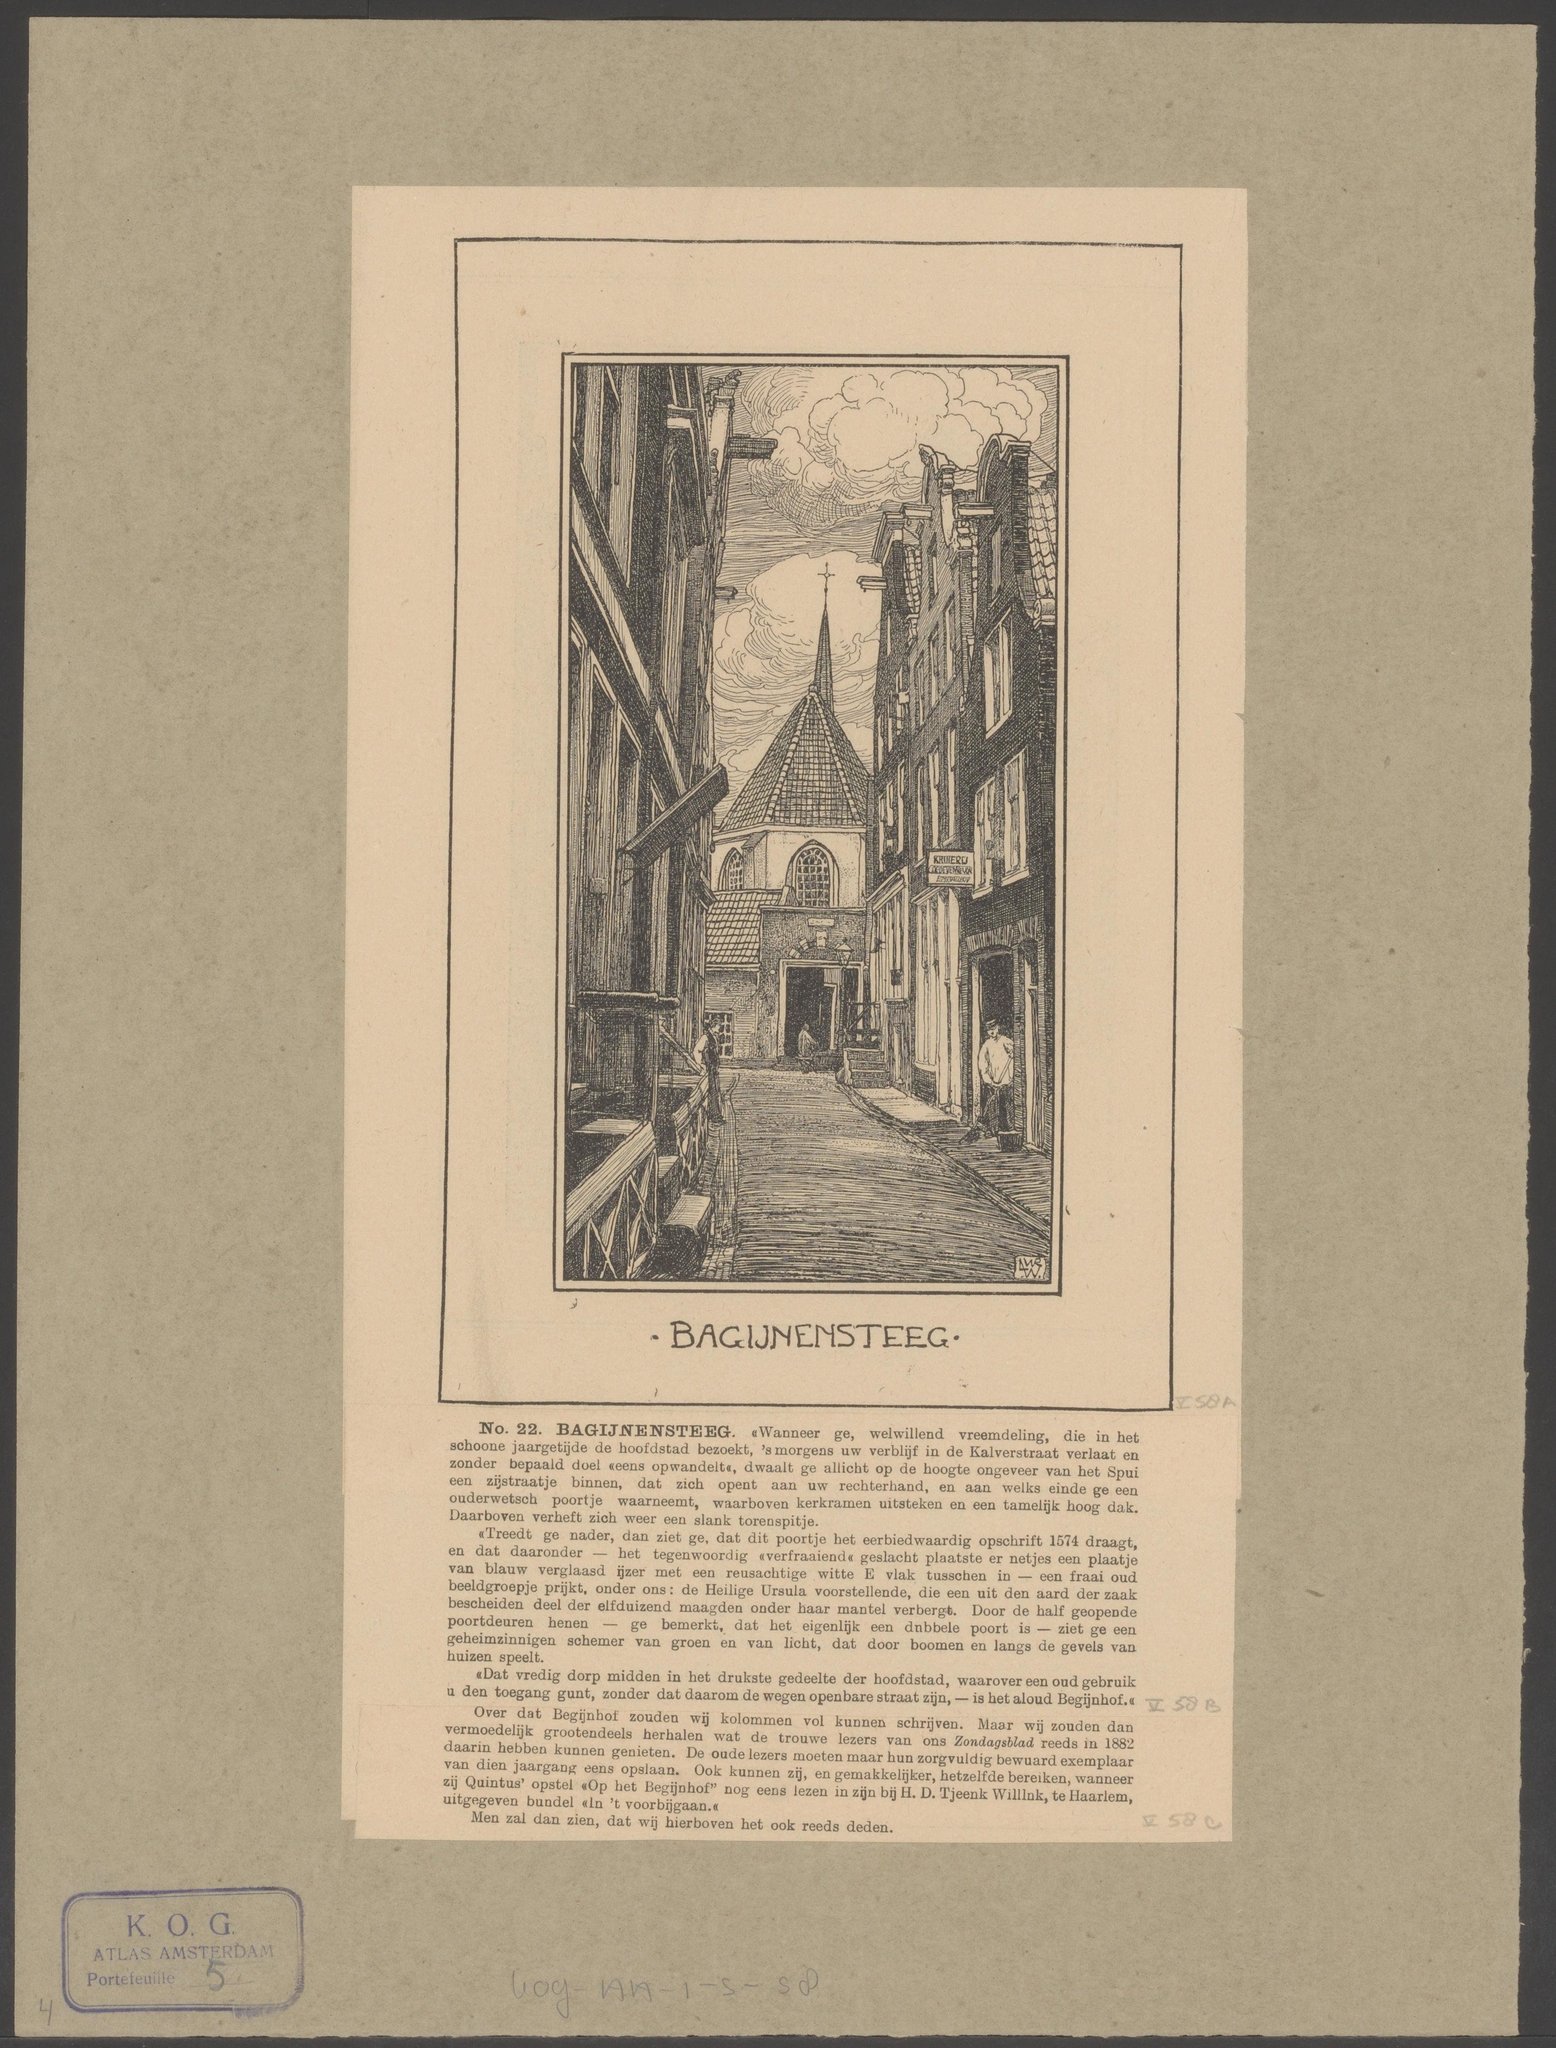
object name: photomechanical print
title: Gezicht op de Begijnensteeg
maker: willem wenckebach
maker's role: designer, draughtsman, painter, print maker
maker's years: 1860-1937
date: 1870-1923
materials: paper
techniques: letterpress printing, line block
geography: amsterdam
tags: city-view in general; 'veduta', church (exterior), the usual house or row of houses, street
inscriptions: collector's mark: ‘5’ Lugt 1641b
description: Onderwerpsrubriek binnen de Atlas Amsterdam: Begijnensloot (Gedempte), Bagijnhofsteeg, Beulingsloot, Bickersgracht en –plein, Bickersstraat (Groote), Bilderdijkskade en -straat, Binnenkant, Blauwburgwal, Boomdwarsstraat, Brouwersgracht, Bleekersspad (Lange), Bleekerssloot, Bloemgracht, Boerenwetering, Boltensgrachtje, Boomssloot (Recht), Badhuisweg.